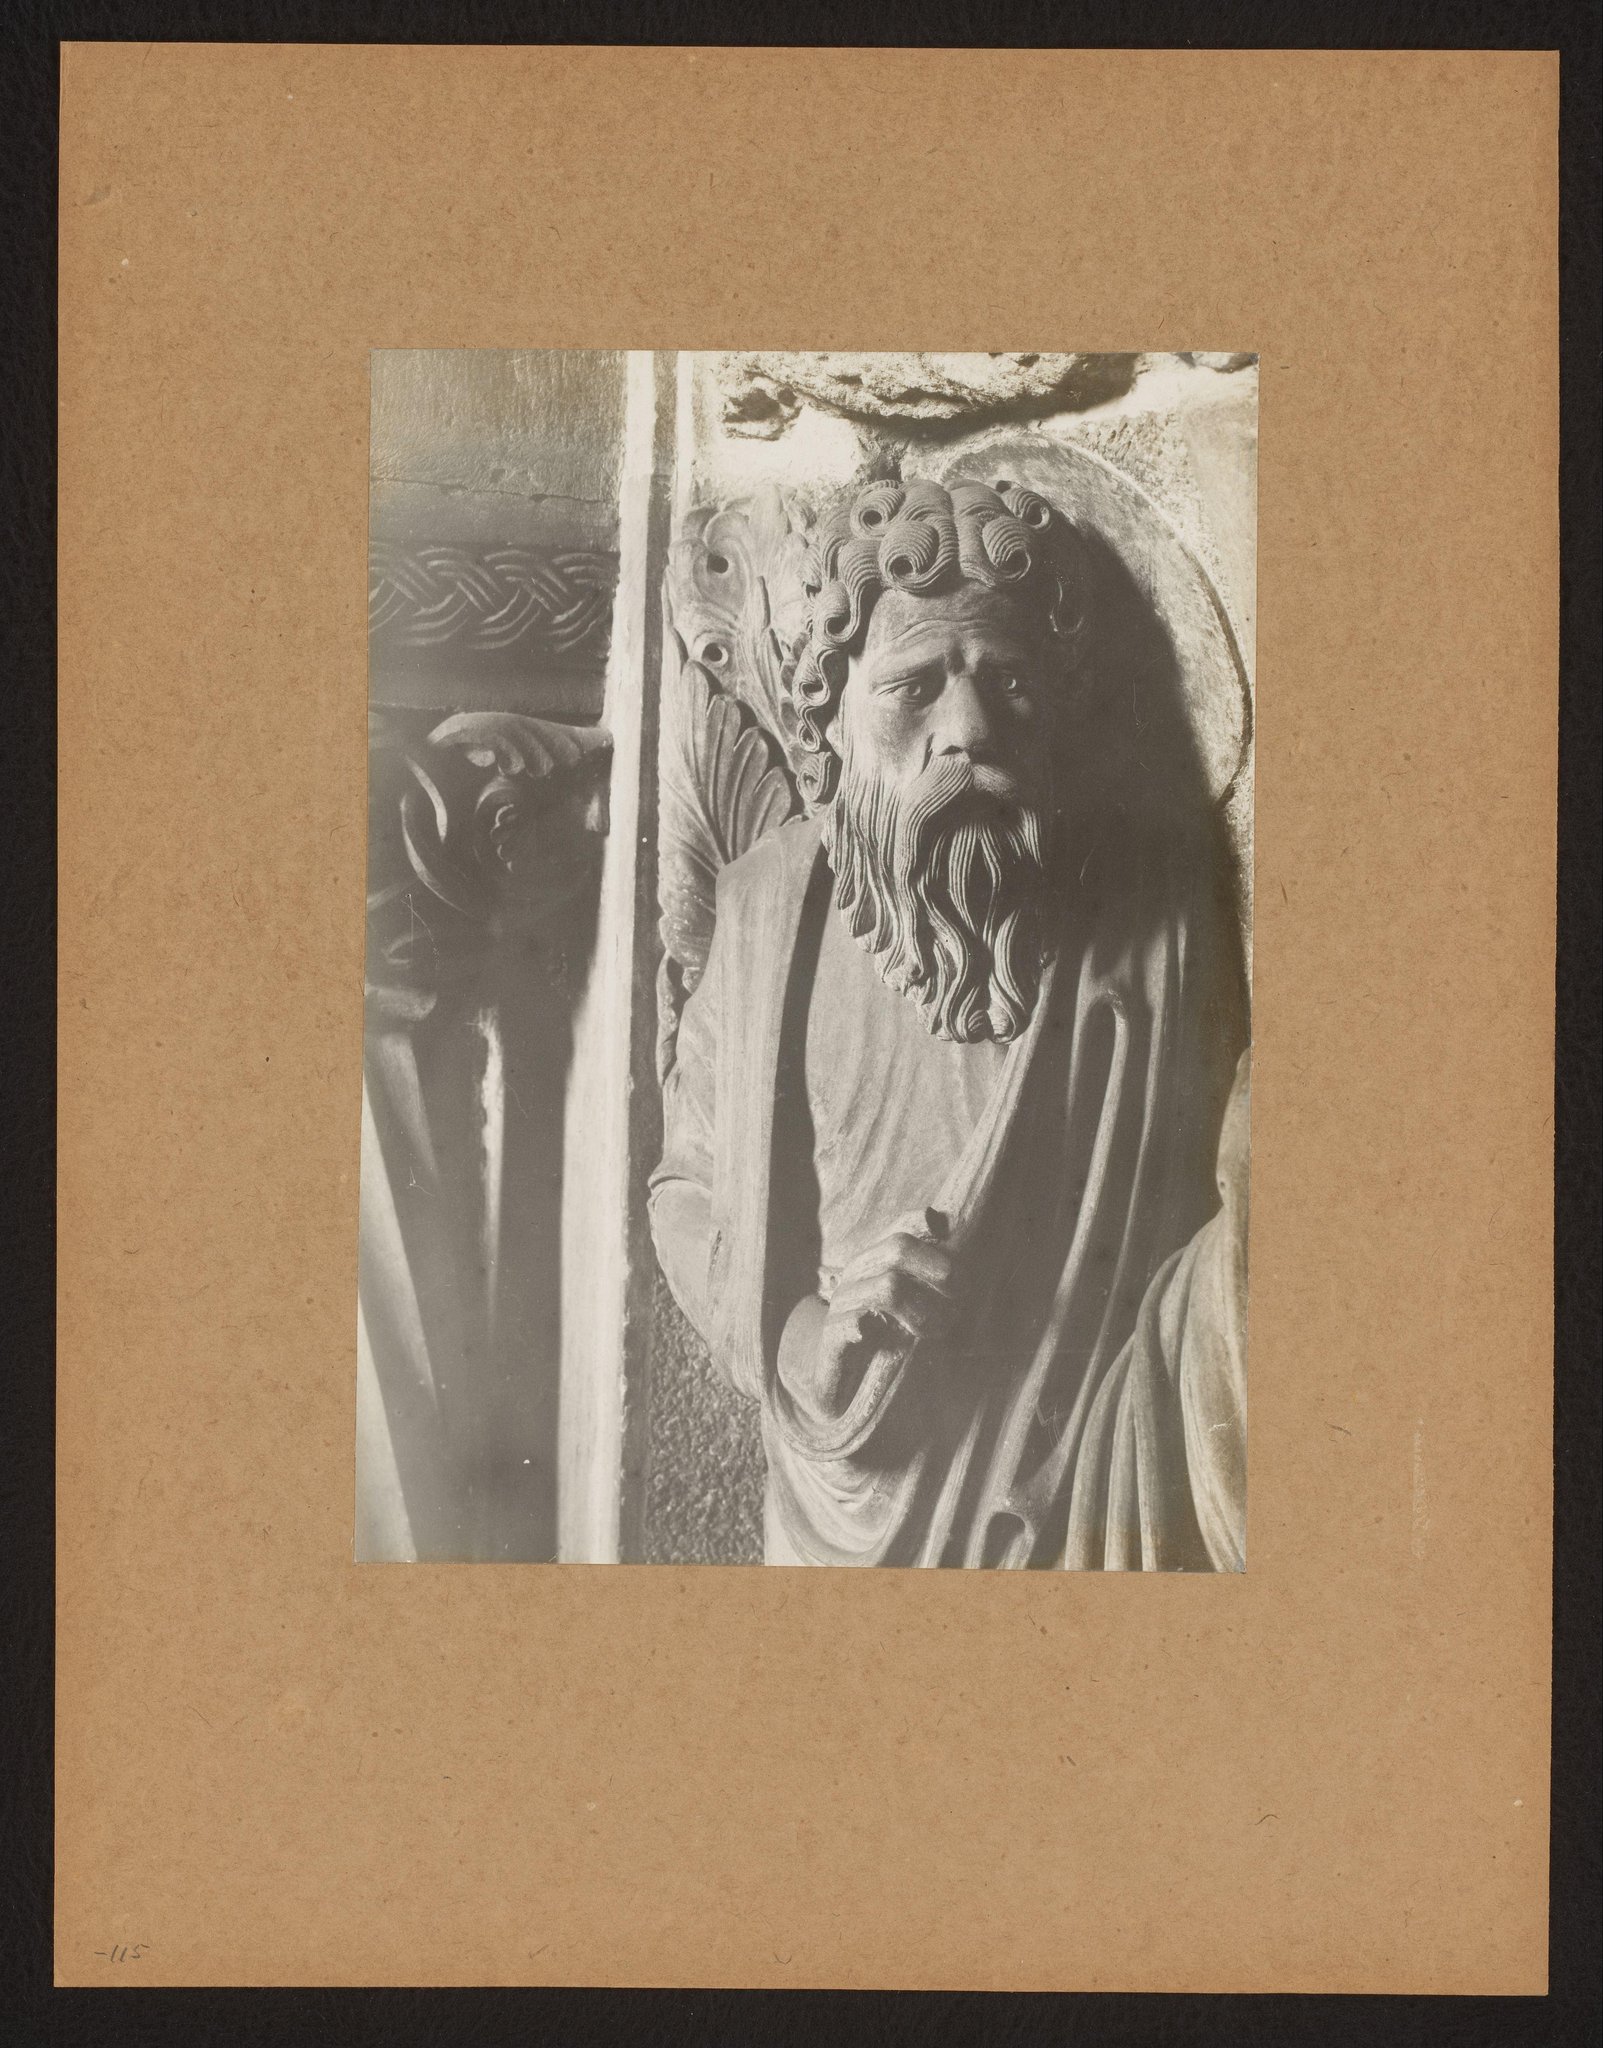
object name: photograph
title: Georgenchorschranken, Prophetenrelief (n.SS) 1.Prophet v.li. (Kopf v.v.)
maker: Anonymous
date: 1900-1920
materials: paper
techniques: gelatin silver print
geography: bamberg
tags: interior of church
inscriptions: number: ‘118.’